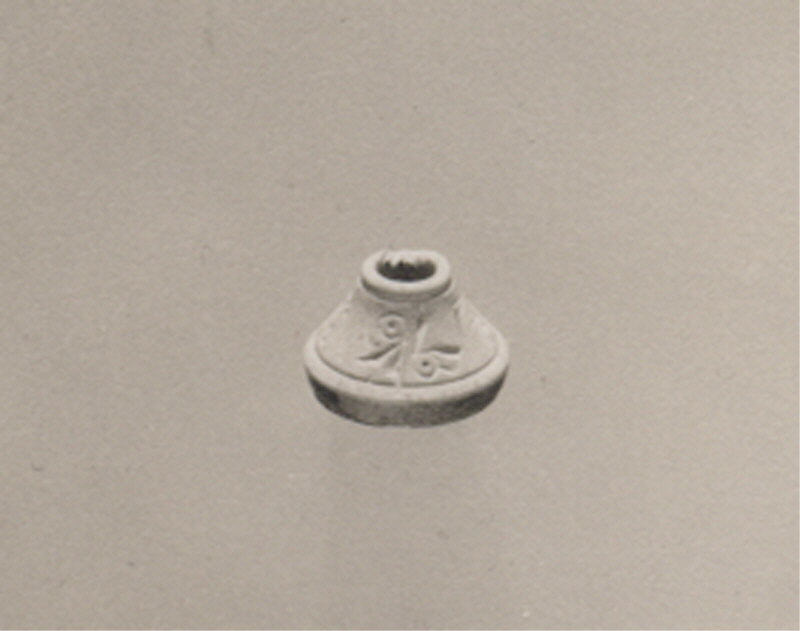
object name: button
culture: sasanian or islamic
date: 501-800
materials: ivory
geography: iran